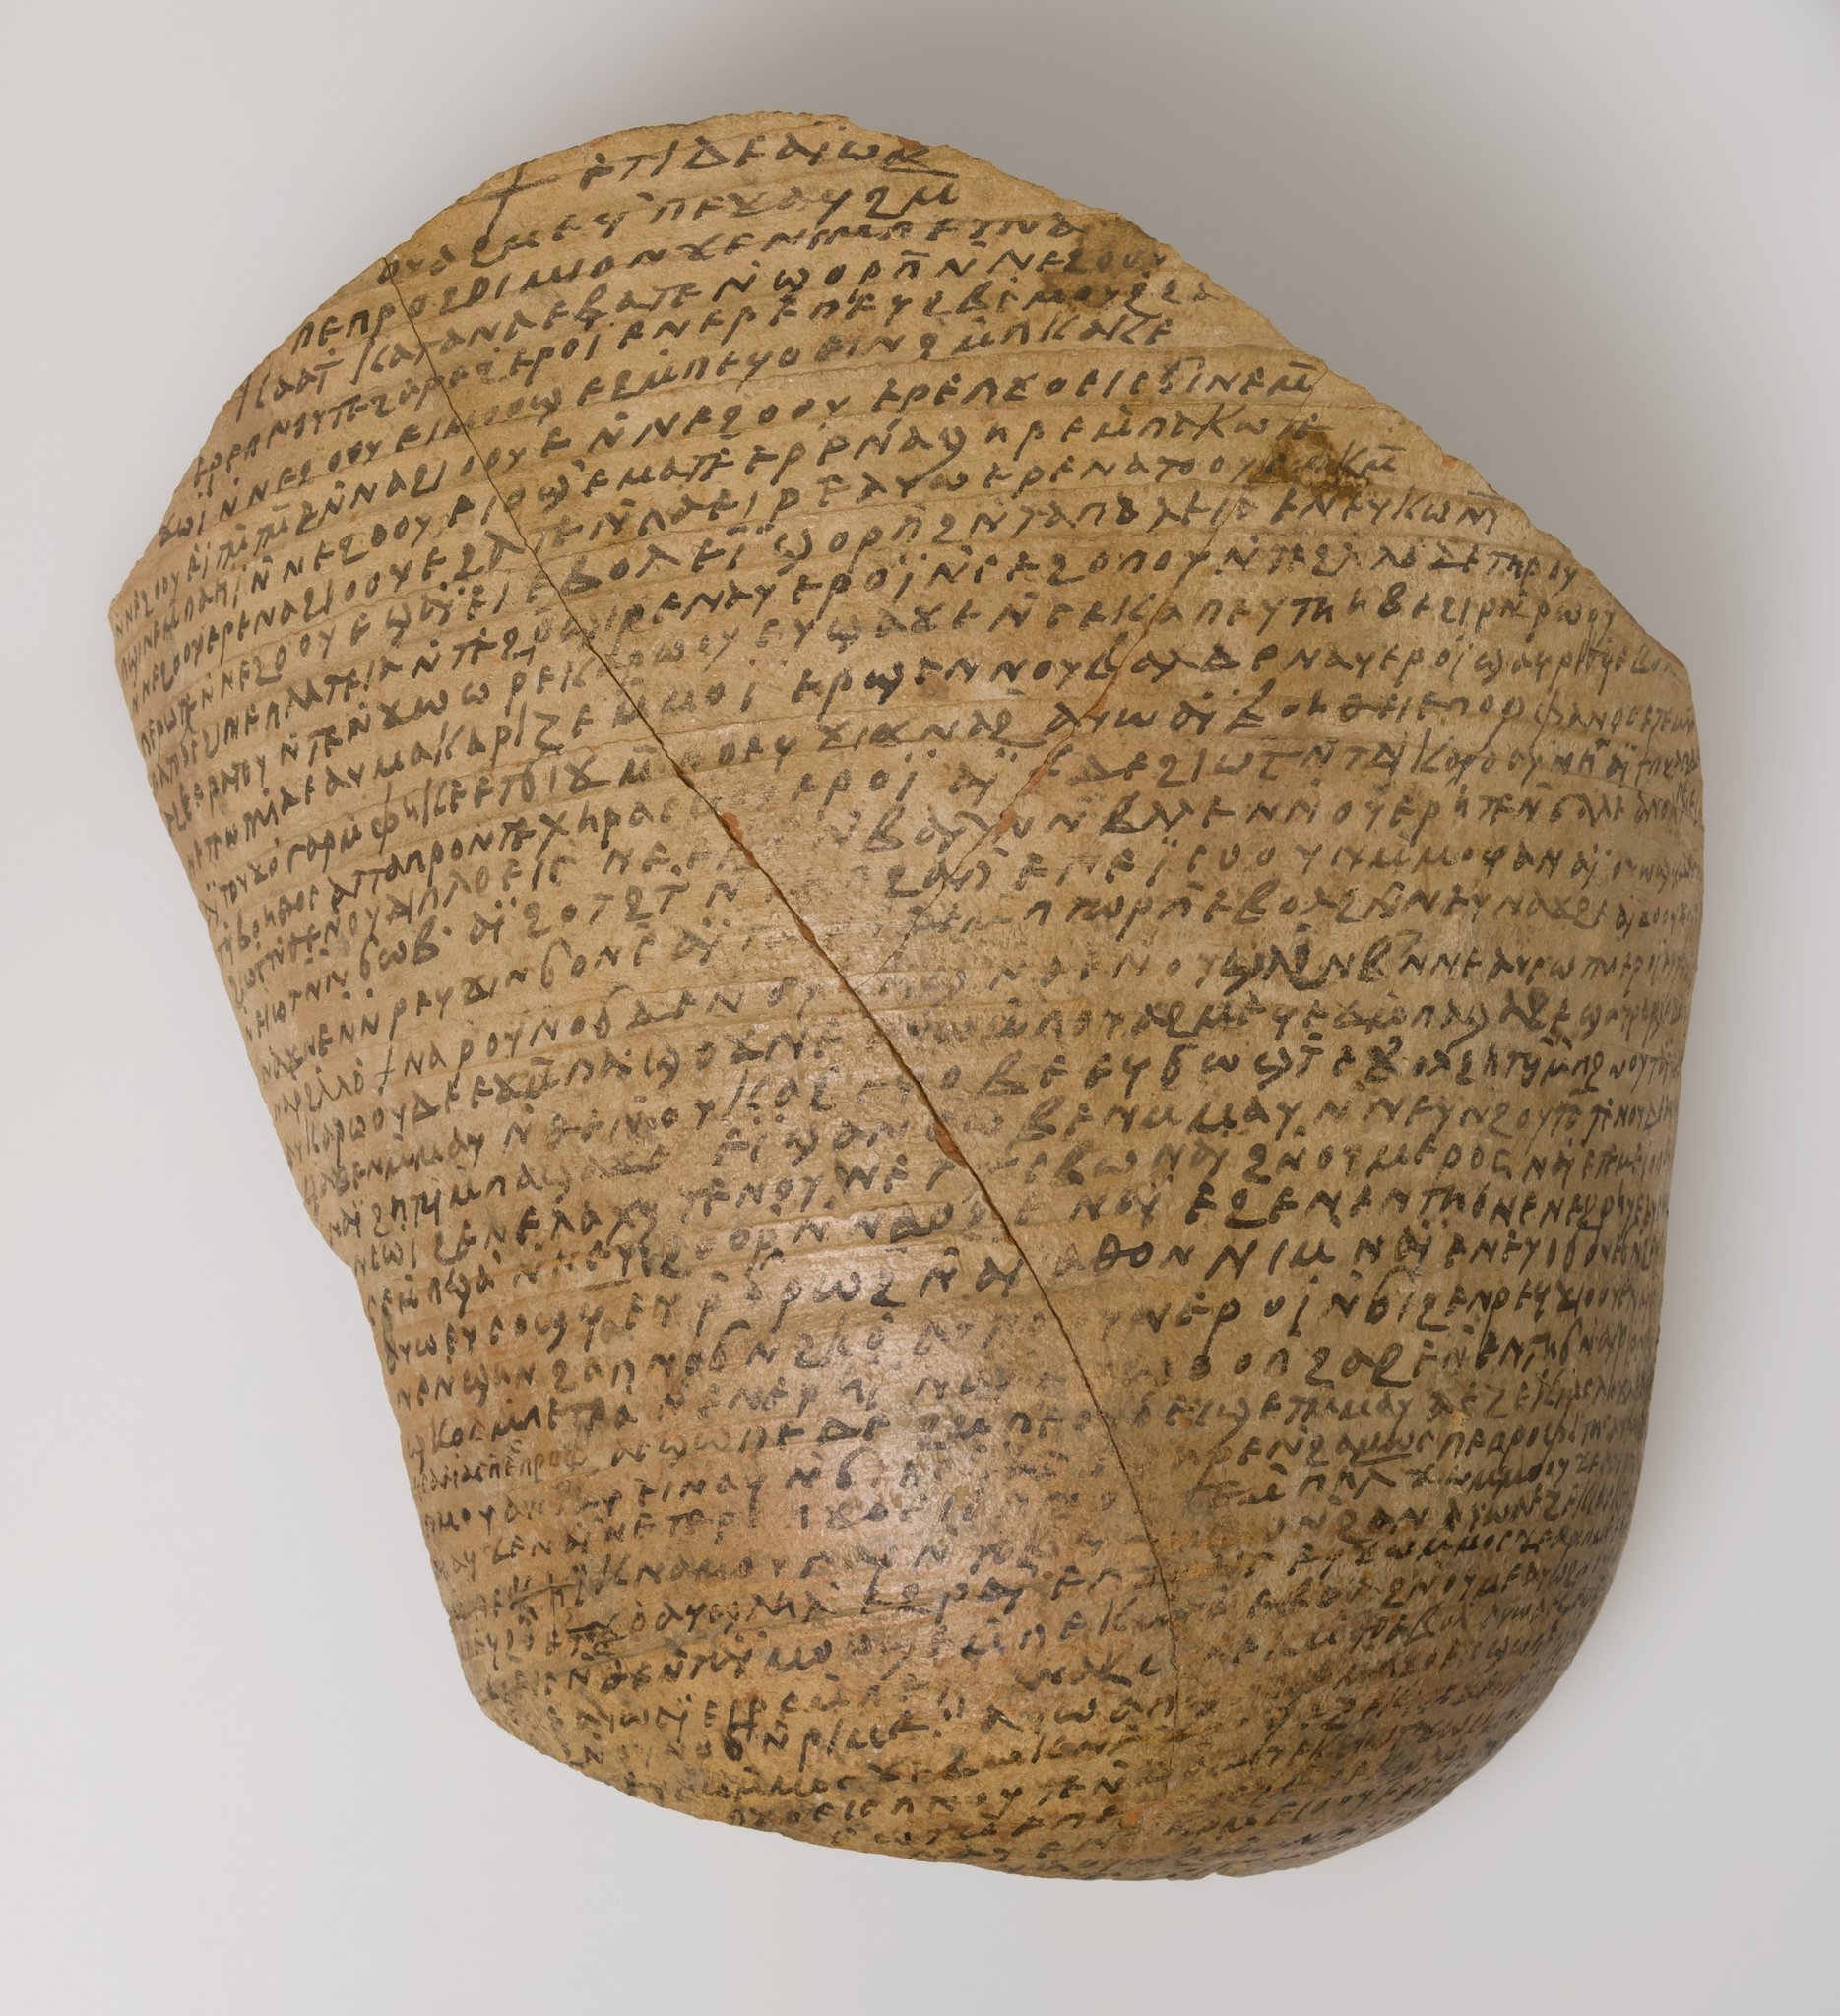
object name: ostrakon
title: Ostrakon with Texts from the Bible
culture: coptic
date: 580-640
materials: ink, pottery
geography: egypt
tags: coptic